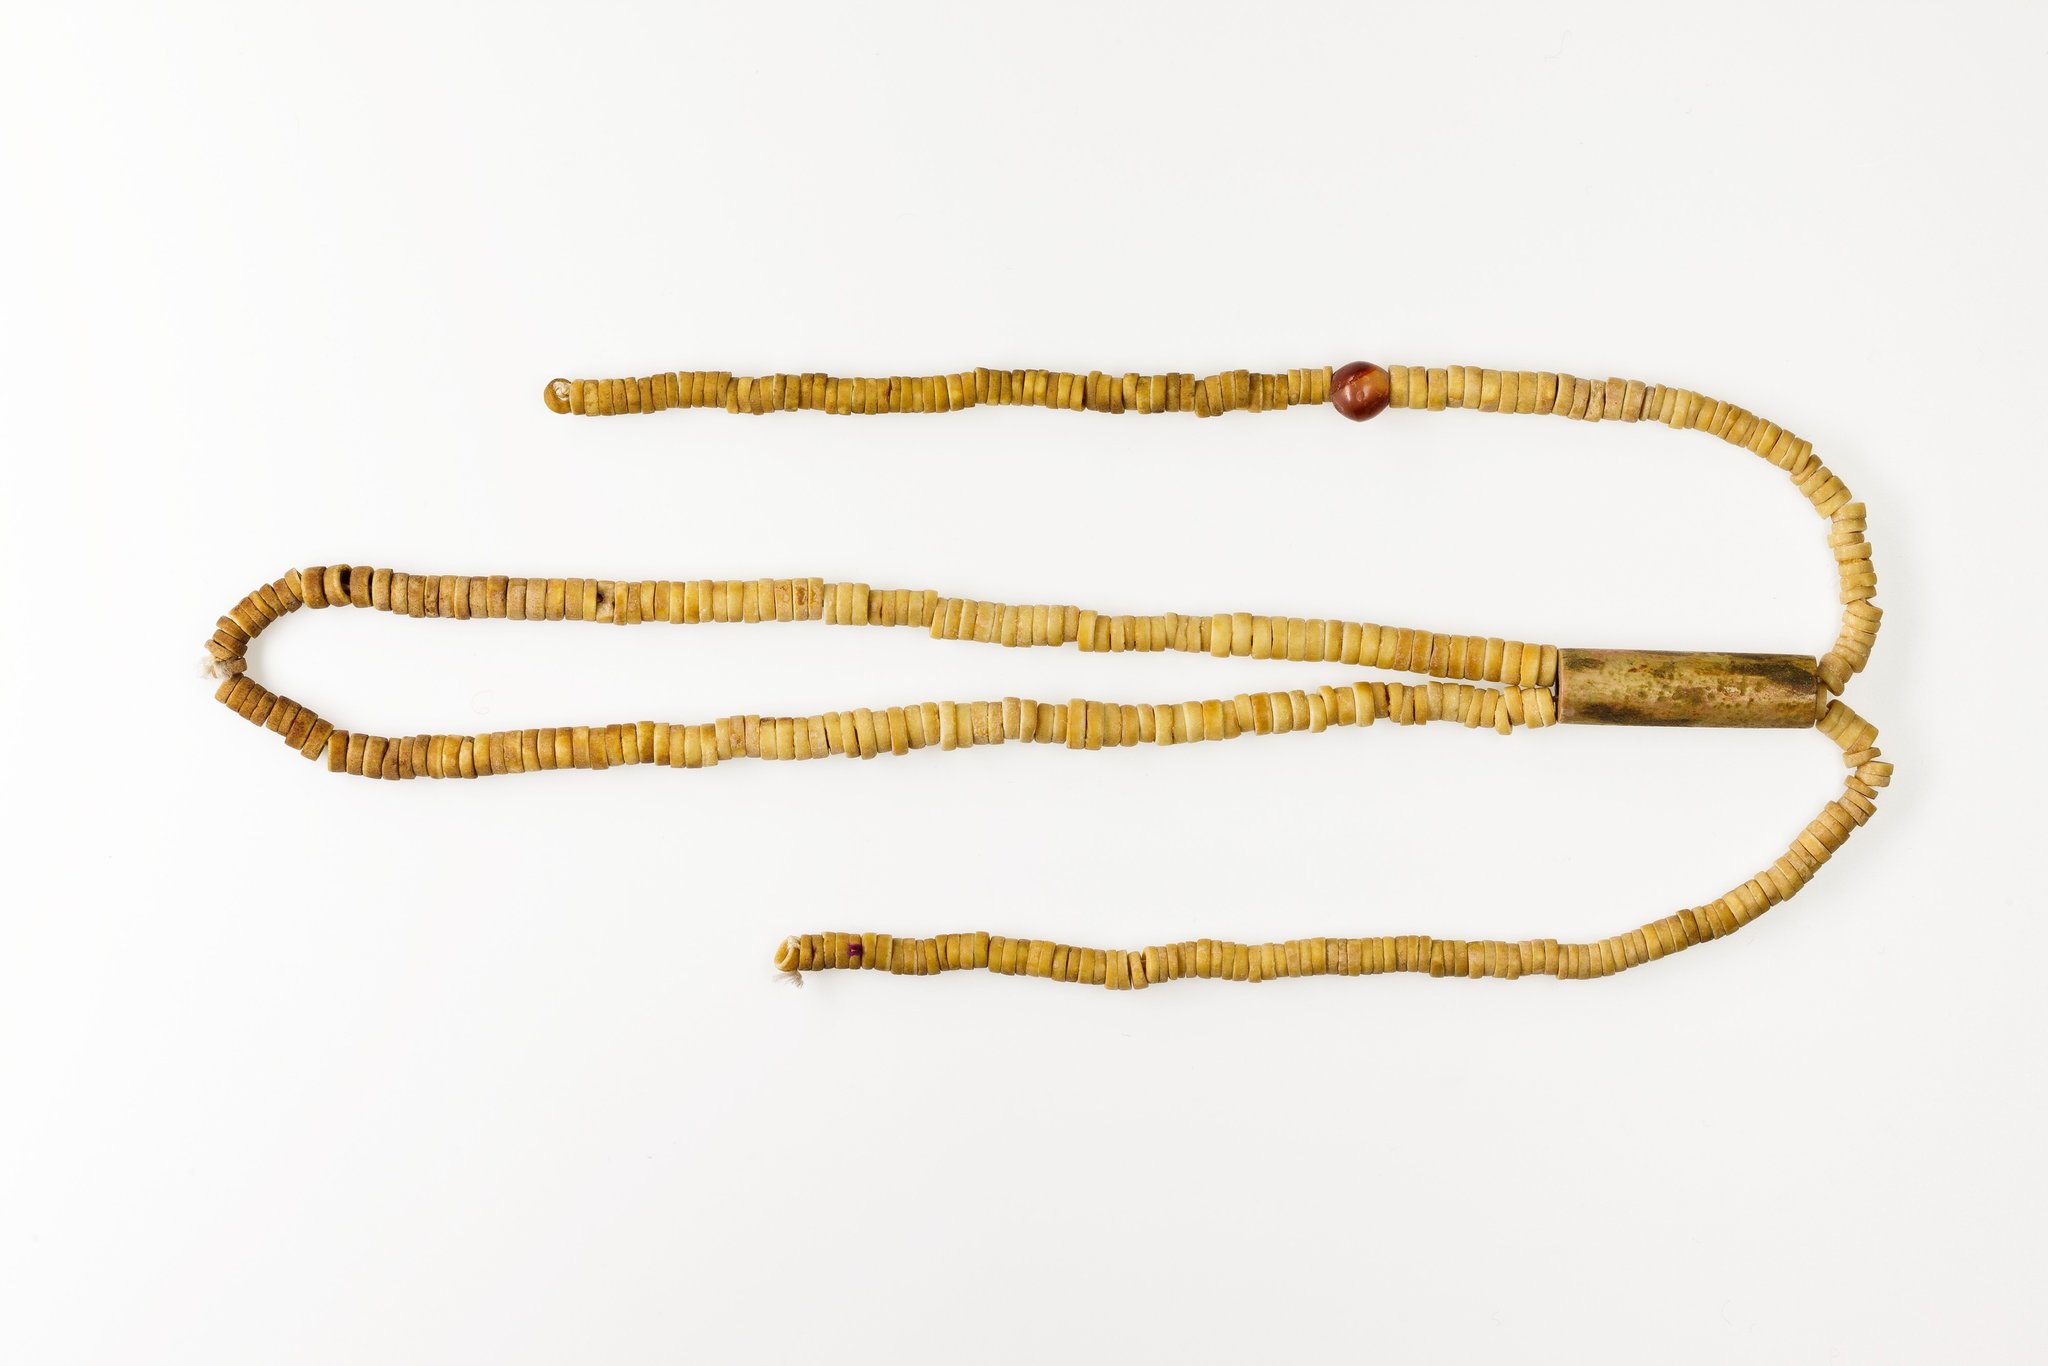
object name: necklace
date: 1981-1640 BCE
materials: gemstone, shell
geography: egypt